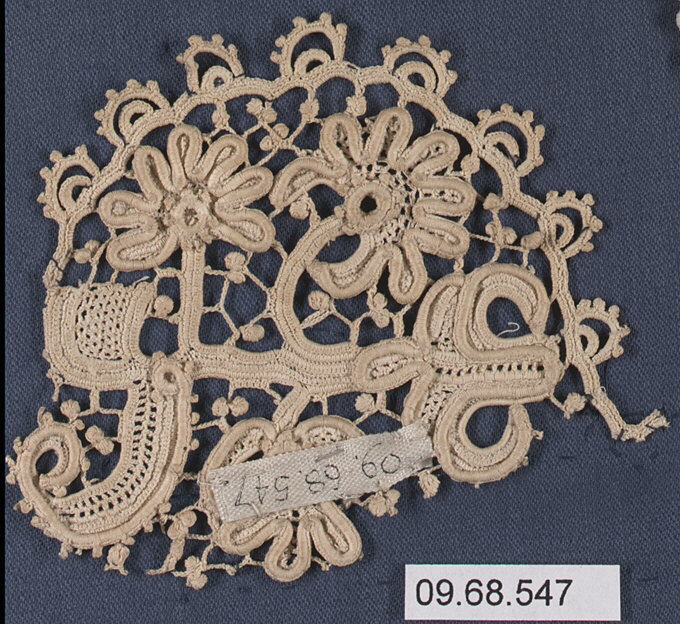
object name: specimen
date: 1801-1900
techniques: crochet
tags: flowers